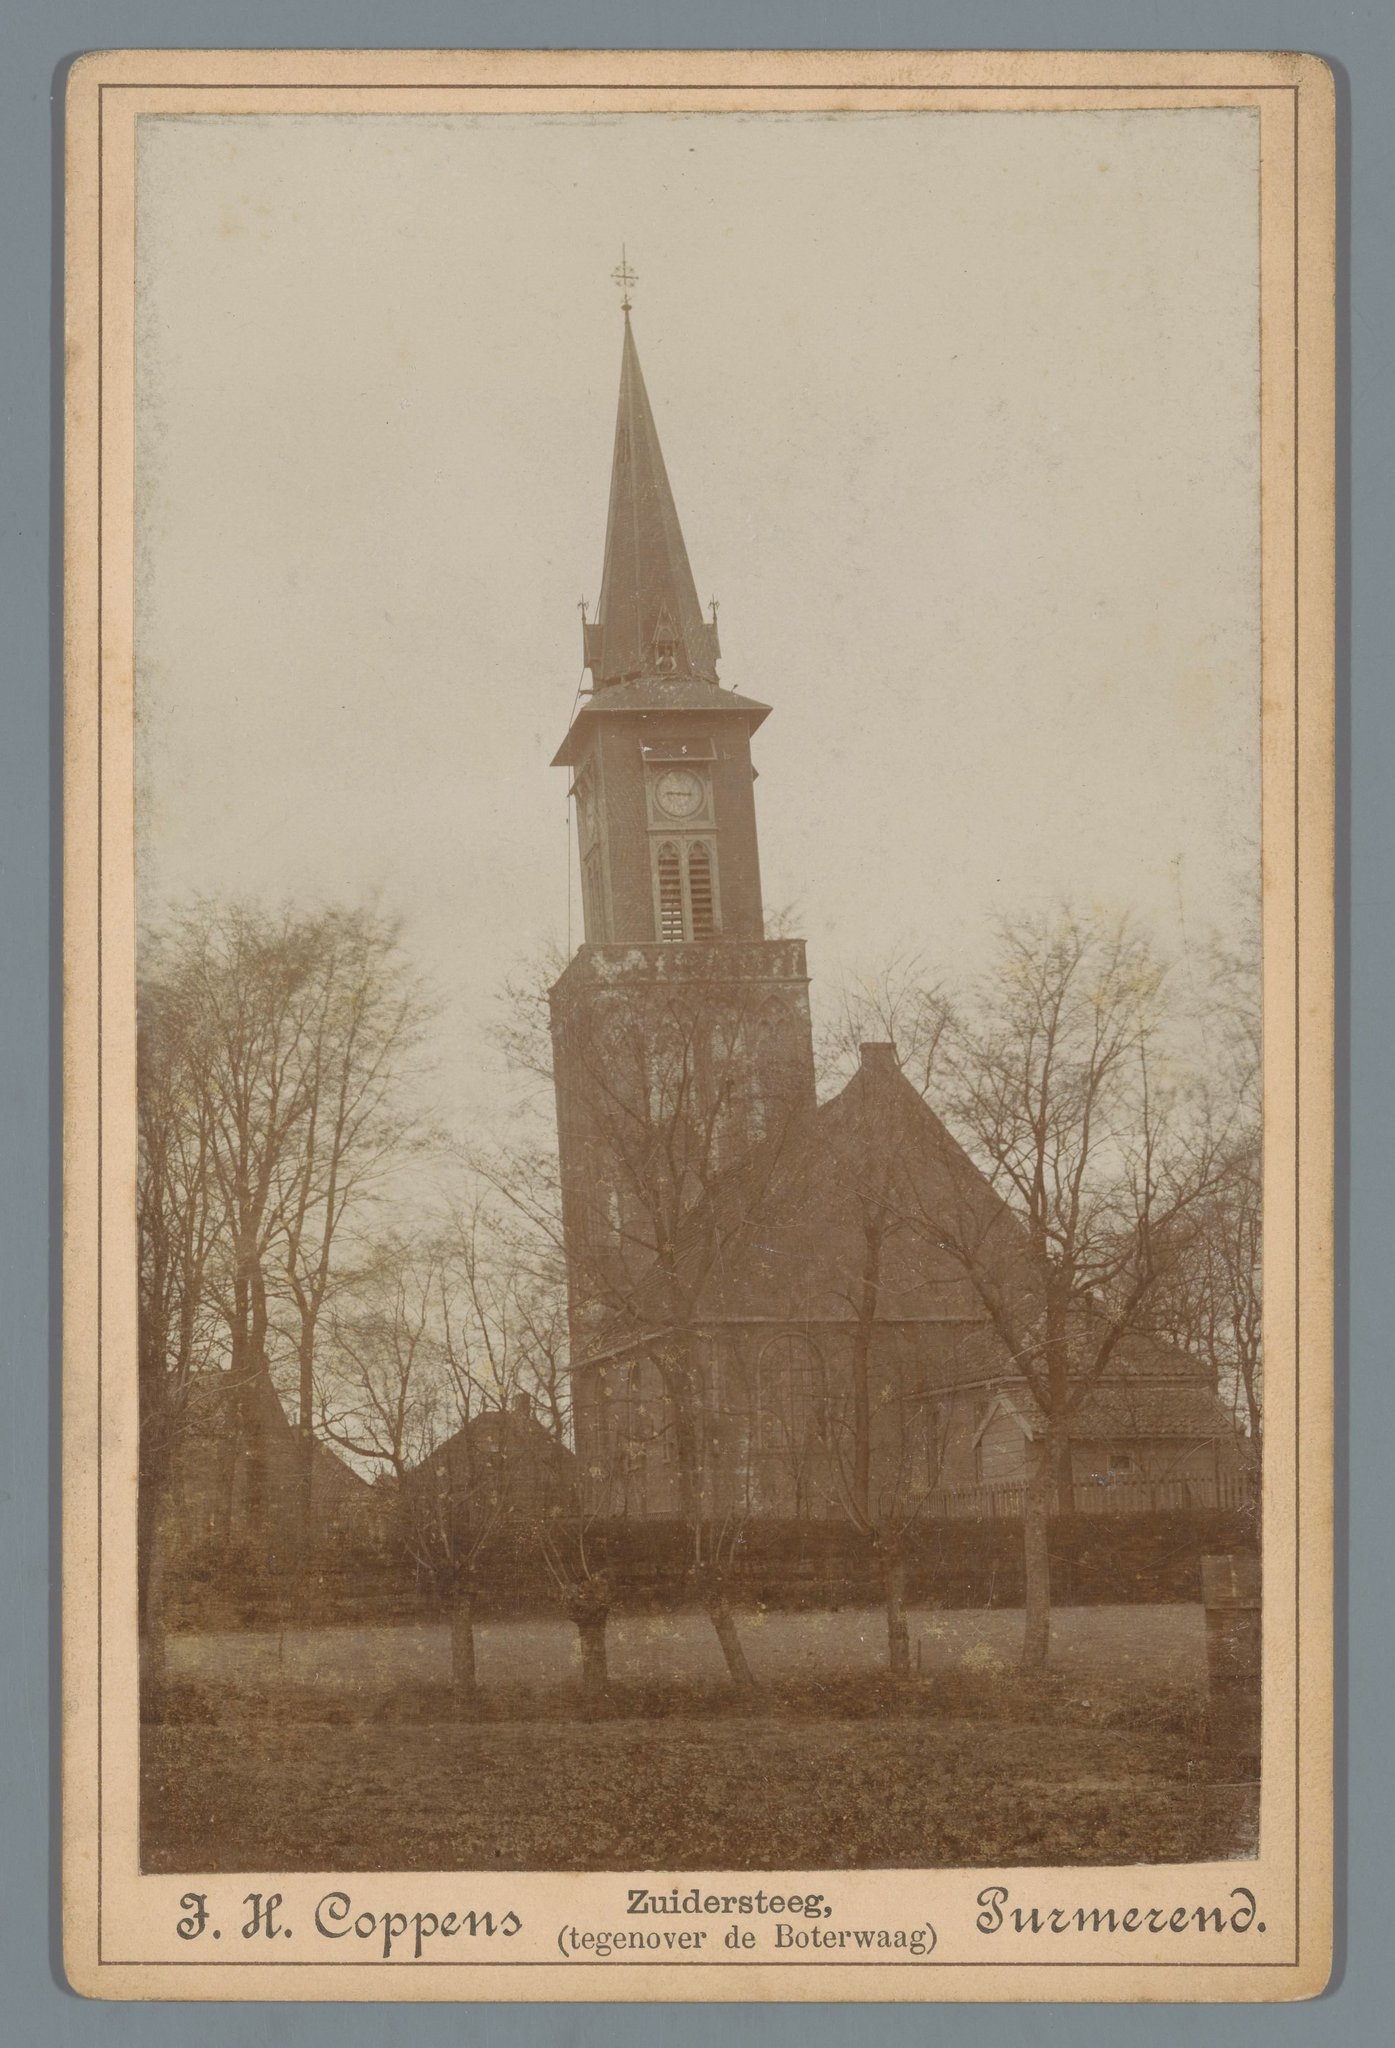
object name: cabinet photograph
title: Gezicht op een kerk te Purmerend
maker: josephus hendrikus petrus coppens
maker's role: fotograaf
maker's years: 1864-1941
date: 1893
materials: paper, cardboard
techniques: gelatin silver print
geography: purmerend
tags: church (exterior)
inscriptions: inscription: ‘toestand 11 april 1893, 2 uur, 1.64 M. uit het lood’